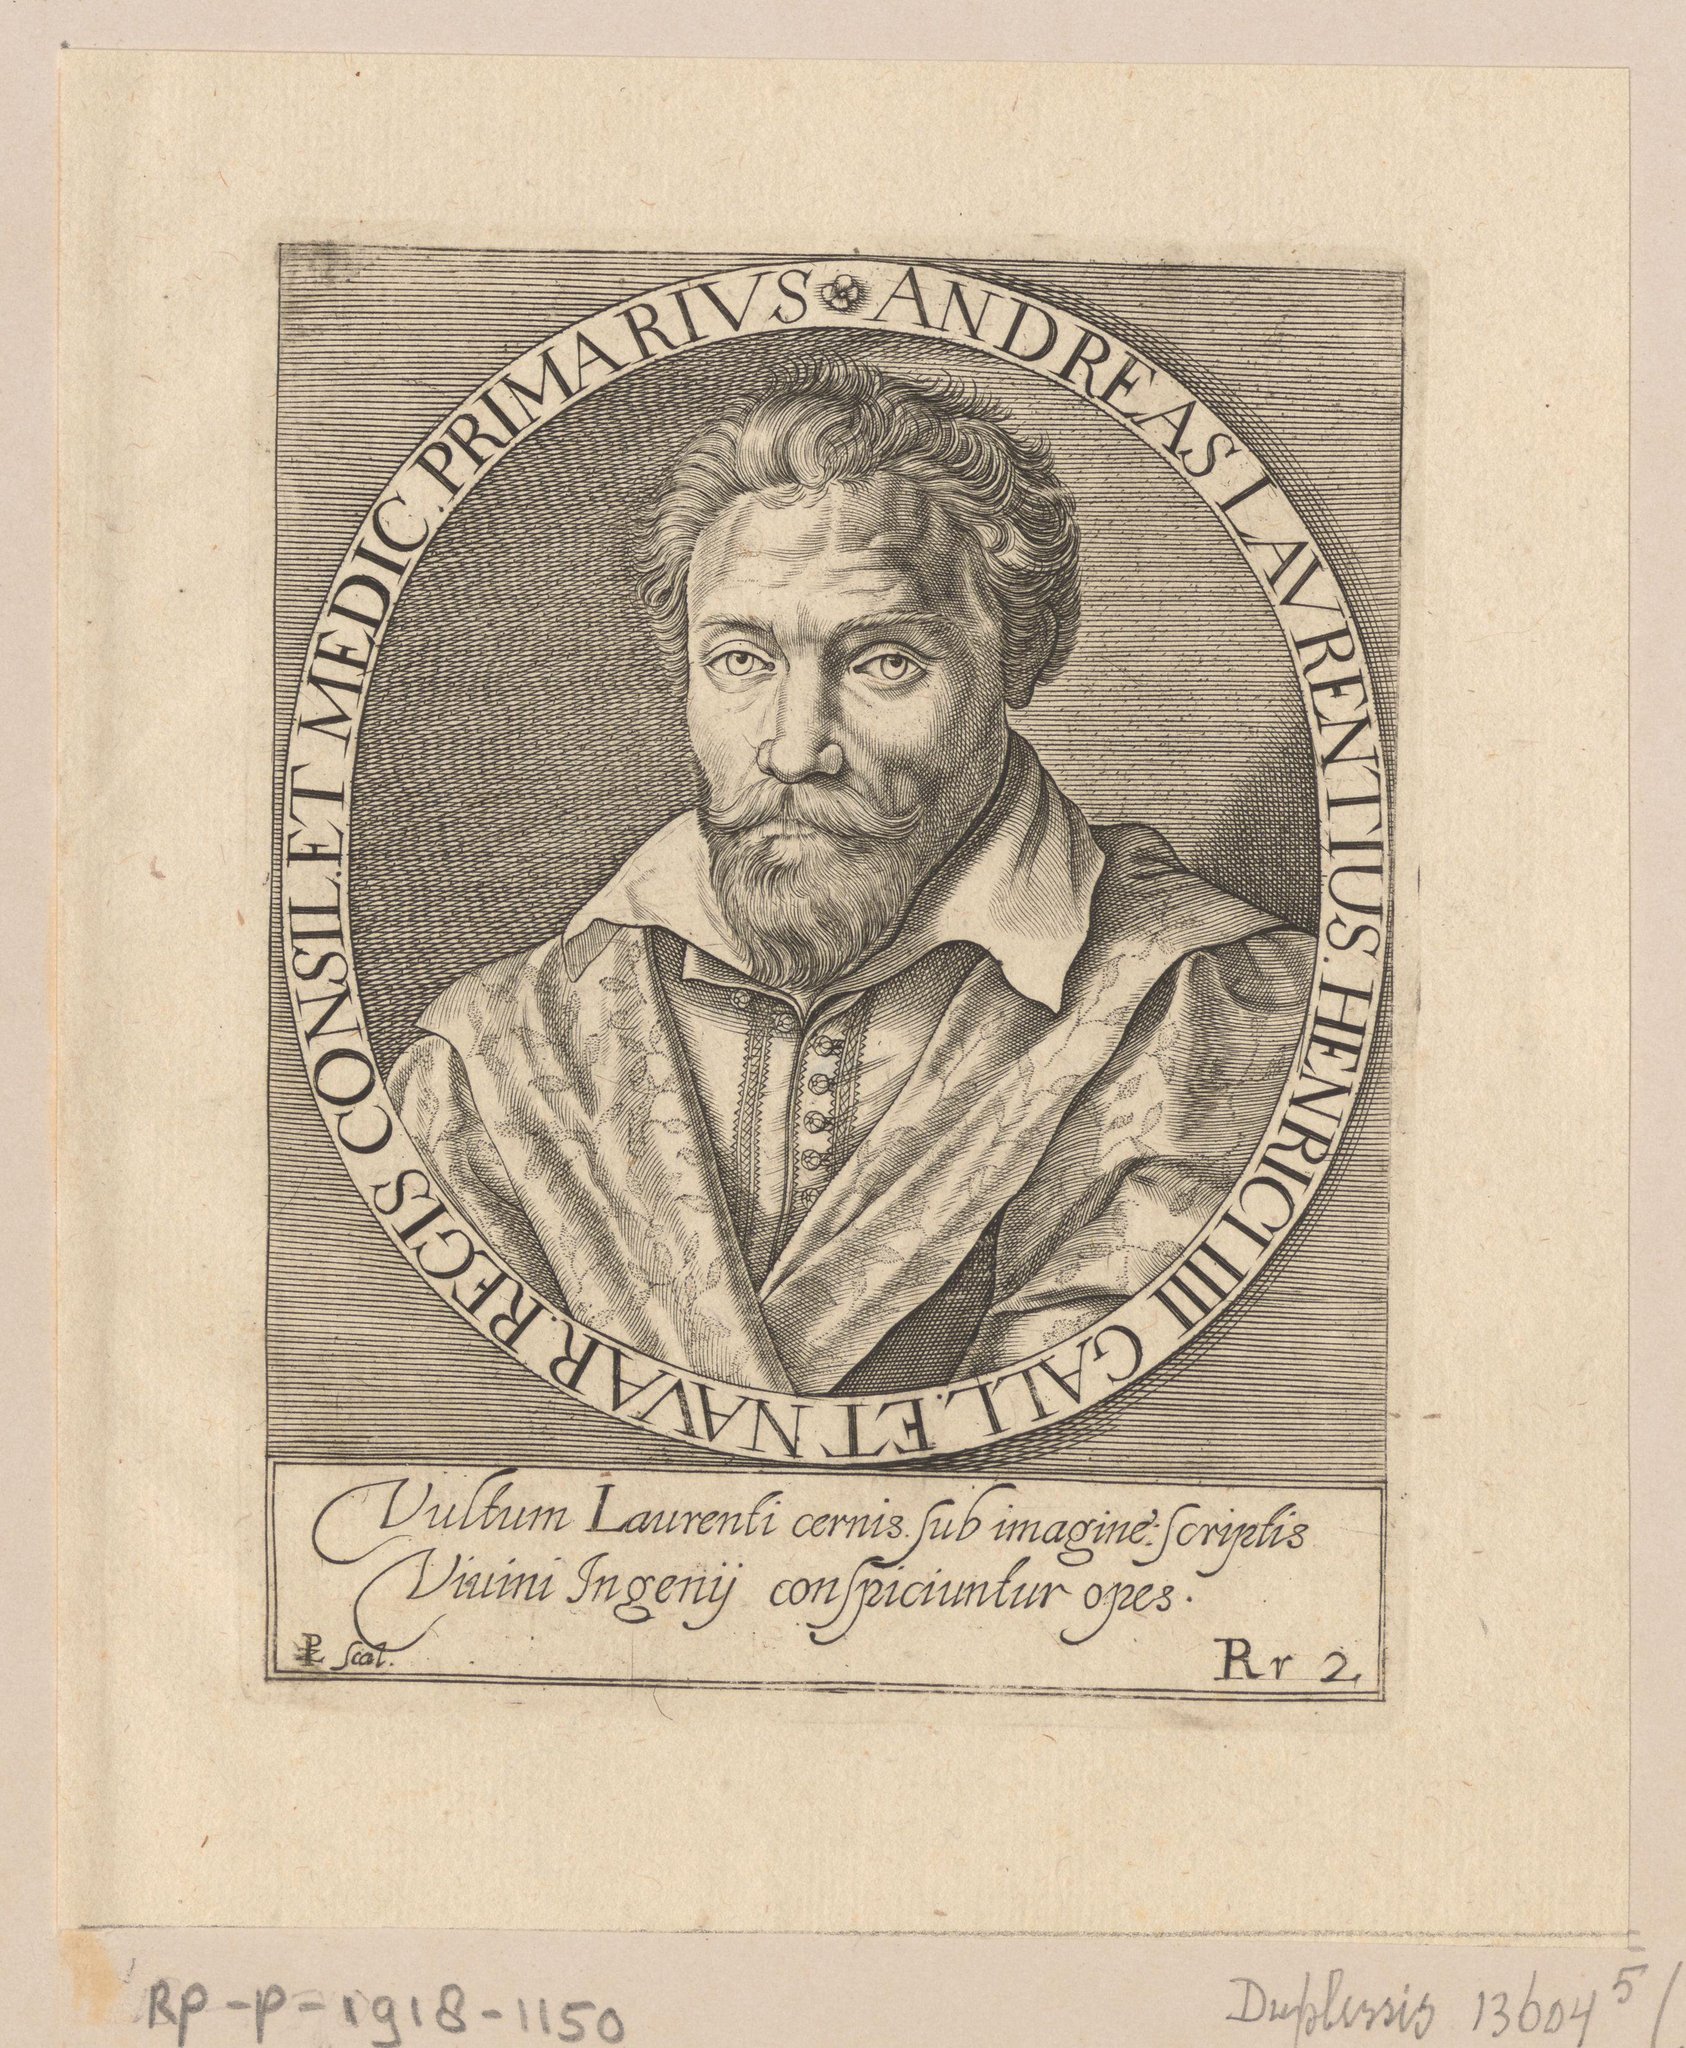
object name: book illustration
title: Bibliotheca chalcographica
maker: paul de zetter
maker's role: print maker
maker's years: 1600-1667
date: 1650-1654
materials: paper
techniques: engraving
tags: historical persons, physician, doctor (+ portrait of scholar, scientist)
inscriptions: collector's mark: Lugt 2233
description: Deze staat is gebruikt in een deel van: Boissard, Jean-Jacques. Bibliotheca Chalcographica Illustrium Virtute (...). Frankfurt am Main: Johannes Ammon, 1650-1654. En in de editie uit 1669. De prent werd voor het eerst gebruikt in een deel van 'Bibliotheca sive Thesaurus Virtutis et Gloriae (...)', 1628-1632.